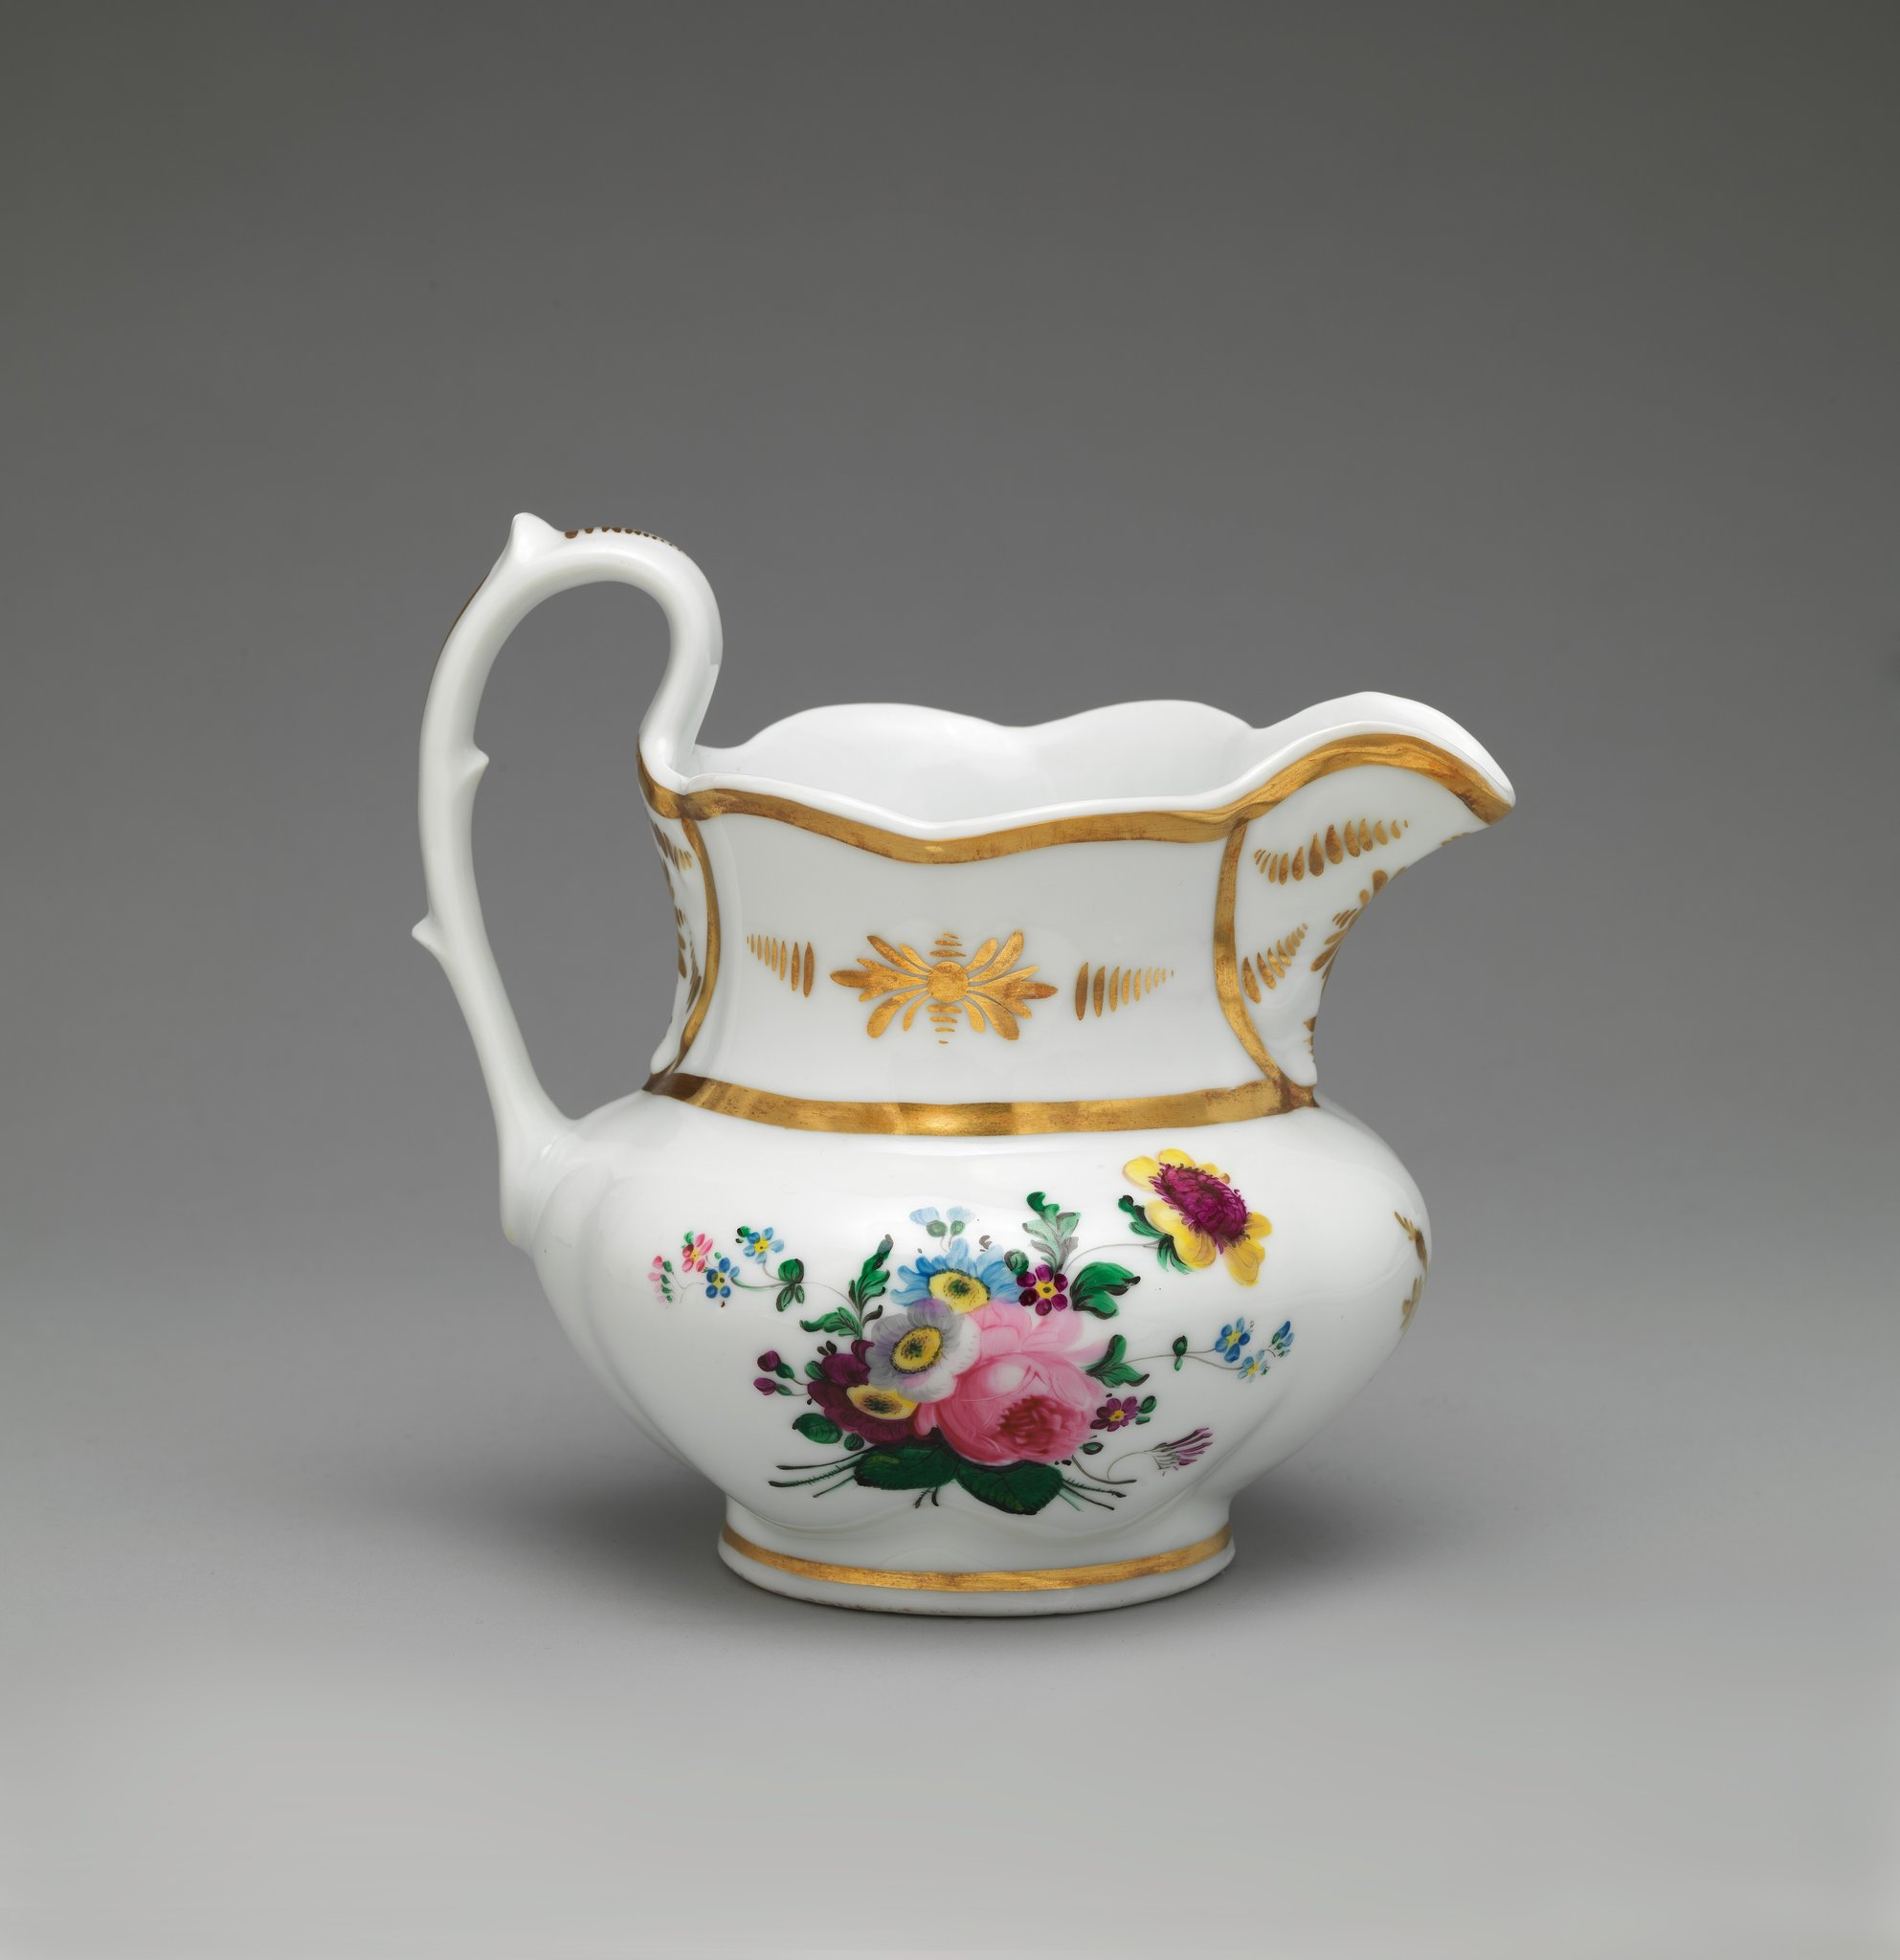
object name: jug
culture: american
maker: tucker and hemphill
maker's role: maker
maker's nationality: american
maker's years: 1831-1837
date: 1832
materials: porcelain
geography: united states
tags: flowers